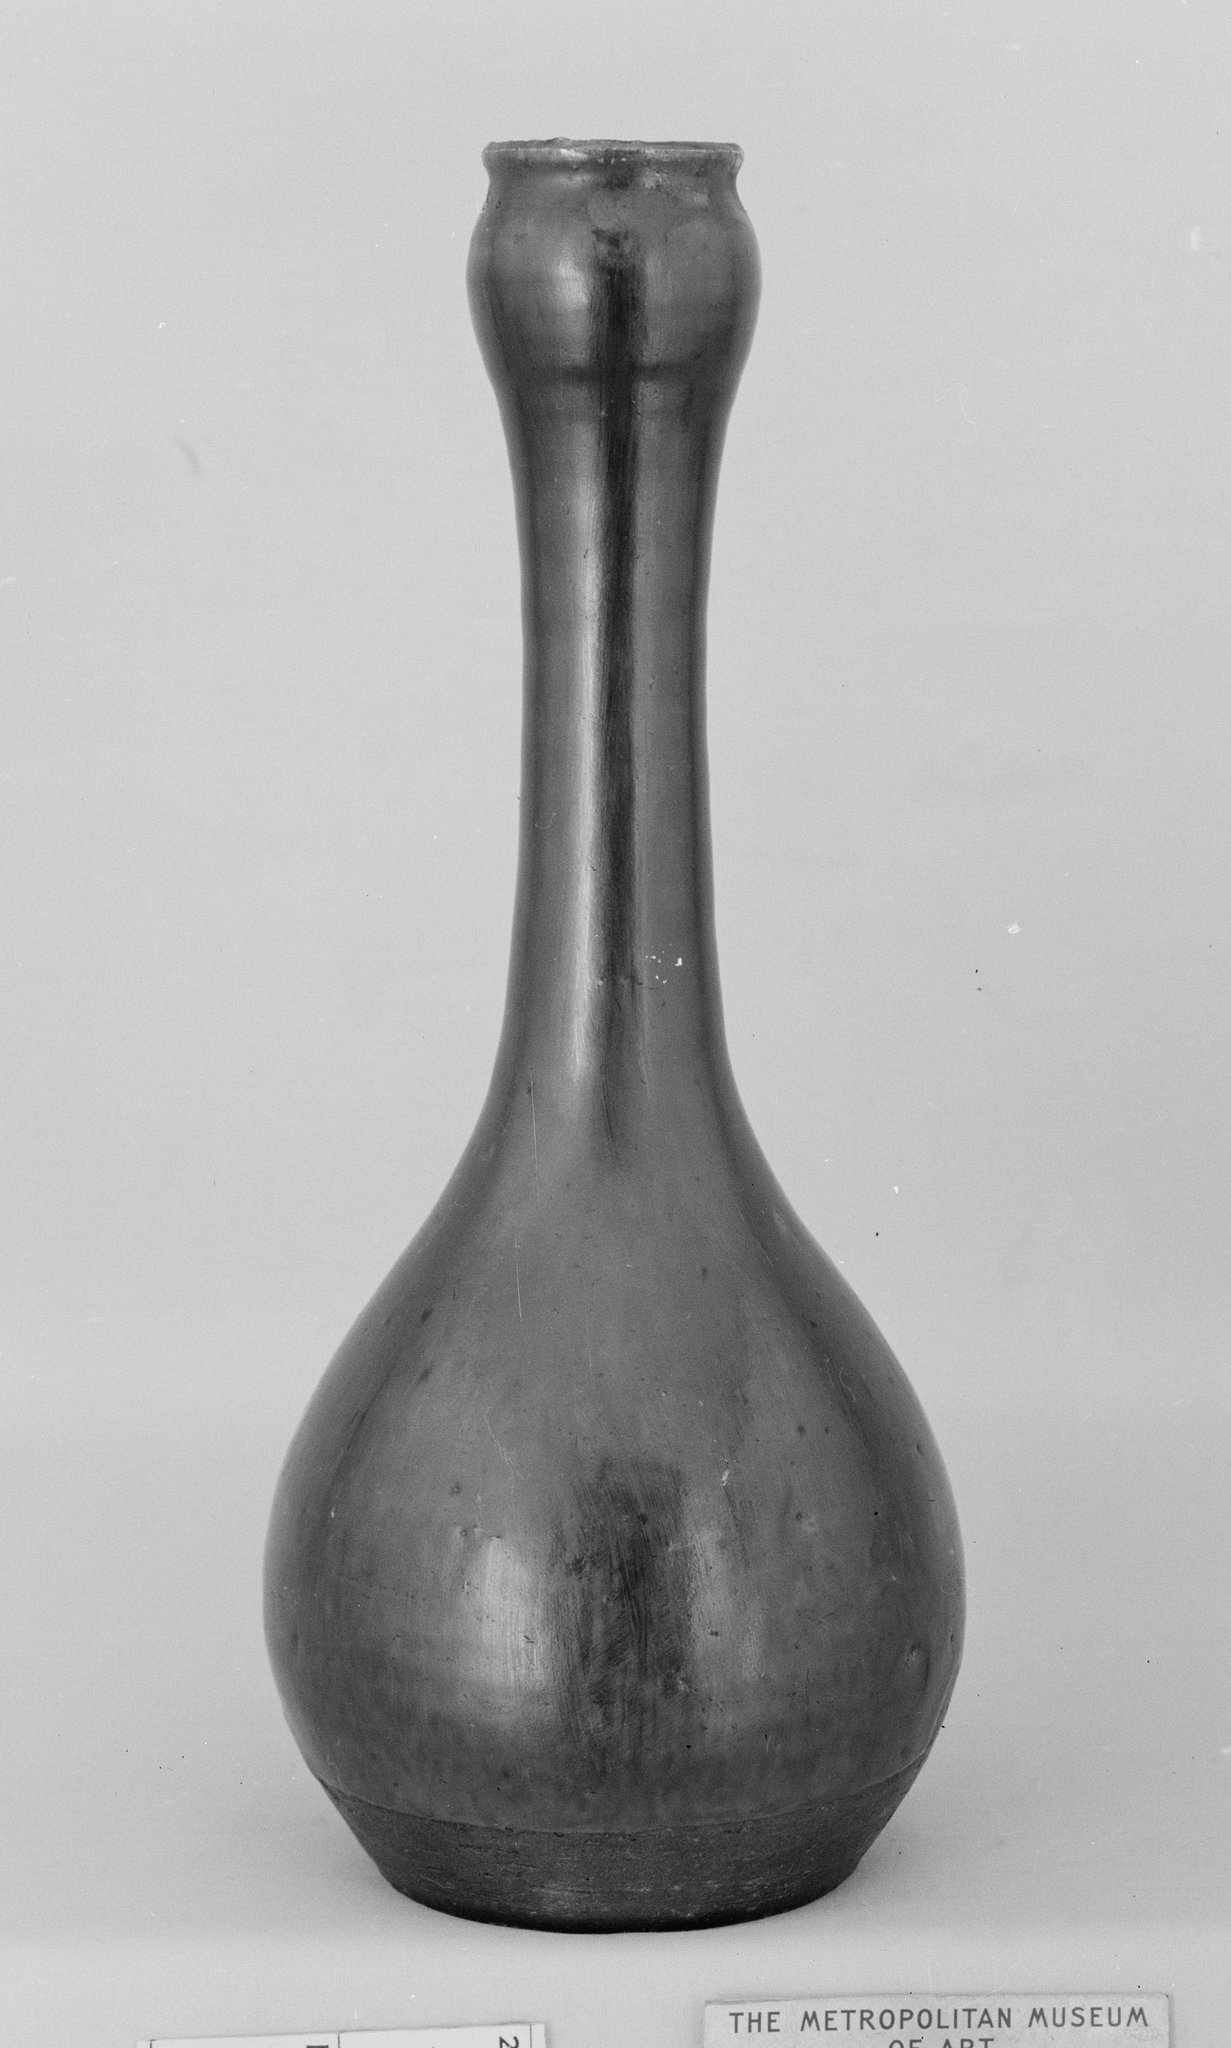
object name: wine bottle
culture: japanese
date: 1701-1800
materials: clay, glaze